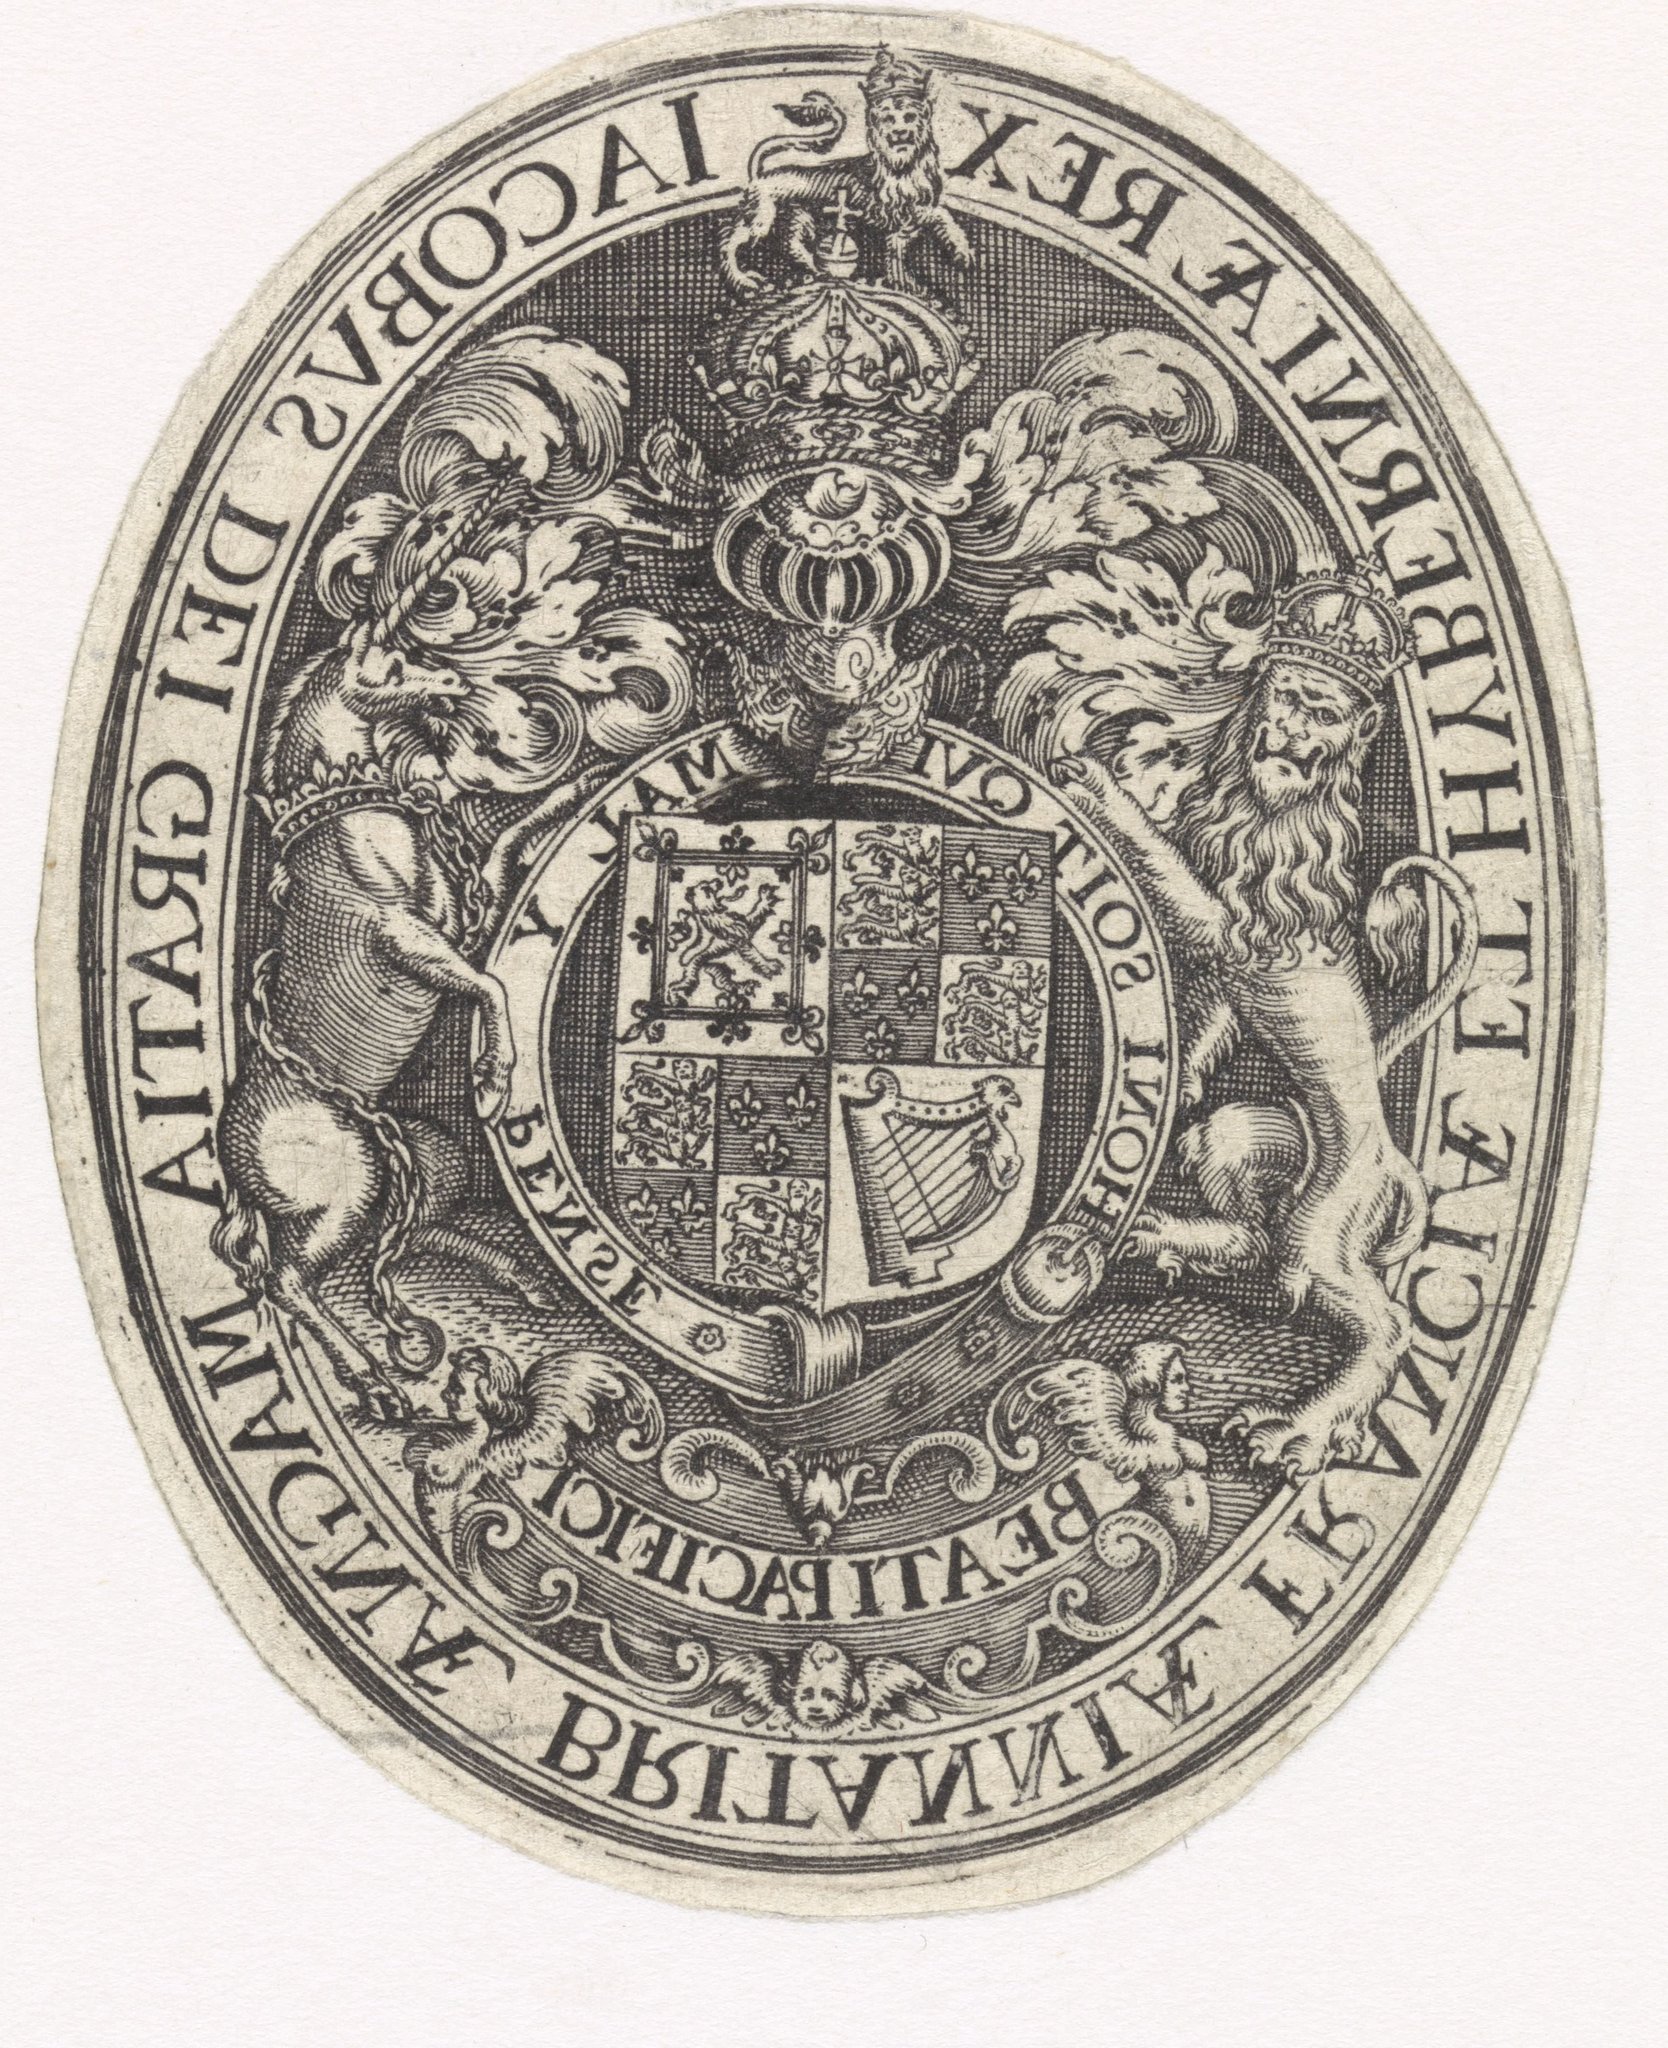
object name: print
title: Wapenschild van Engeland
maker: simon van de passe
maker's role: print maker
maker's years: 1595-1647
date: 1615-1622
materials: paper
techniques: engraving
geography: london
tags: jacobus i (koning van engeland), knighthood order (garter)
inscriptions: collector's mark: Lugt 2228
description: Medaillon met het wapenschild van Engeland. In het midden het devies van de Orde van de Kousenband in het Latijn (Schande over hem die er kwaad van denkt). In het randschrift de naam en functie van de, op de voorzijde, geportretteerde in het Latijn. Op de voorzijde van de medaille het portret van James I.